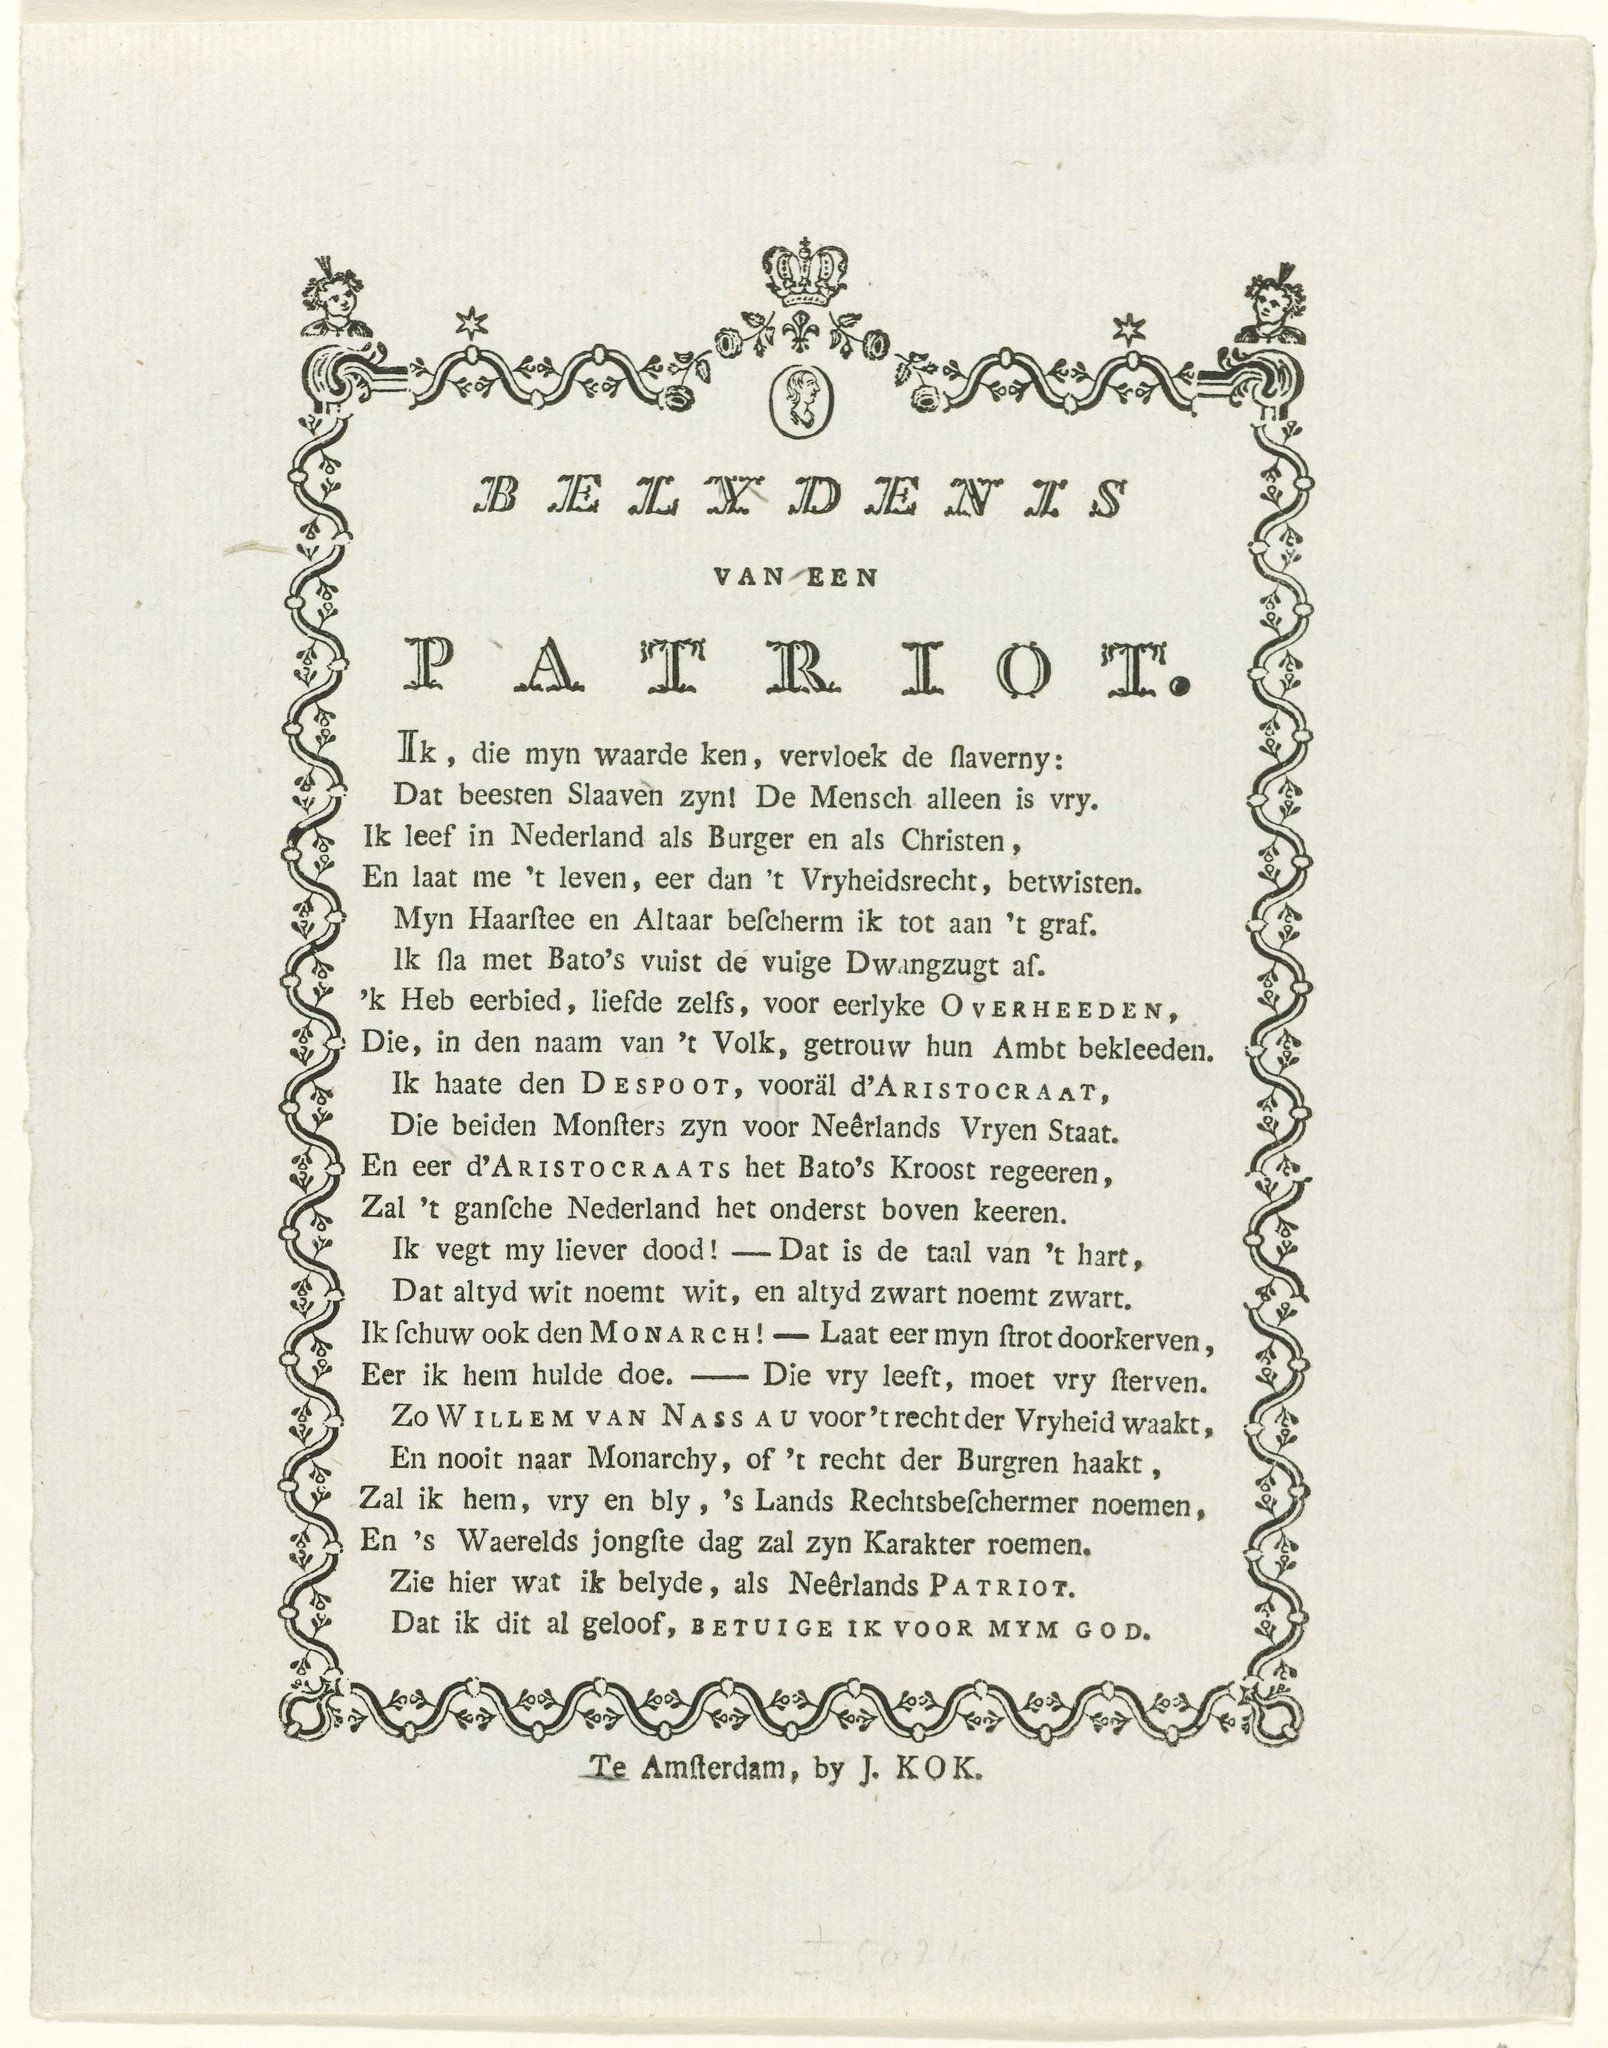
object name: text sheet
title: Belijdenis van een Patriot, 1787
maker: jacobus kok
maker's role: publisher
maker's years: -1788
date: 1787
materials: paper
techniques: letterpress printing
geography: amsterdam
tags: patriots (1780-1795)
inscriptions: collector's mark: Lugt 2228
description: Tekstblad met een patriots vers in de vorm van een belijdenis van een patriot, 1787.